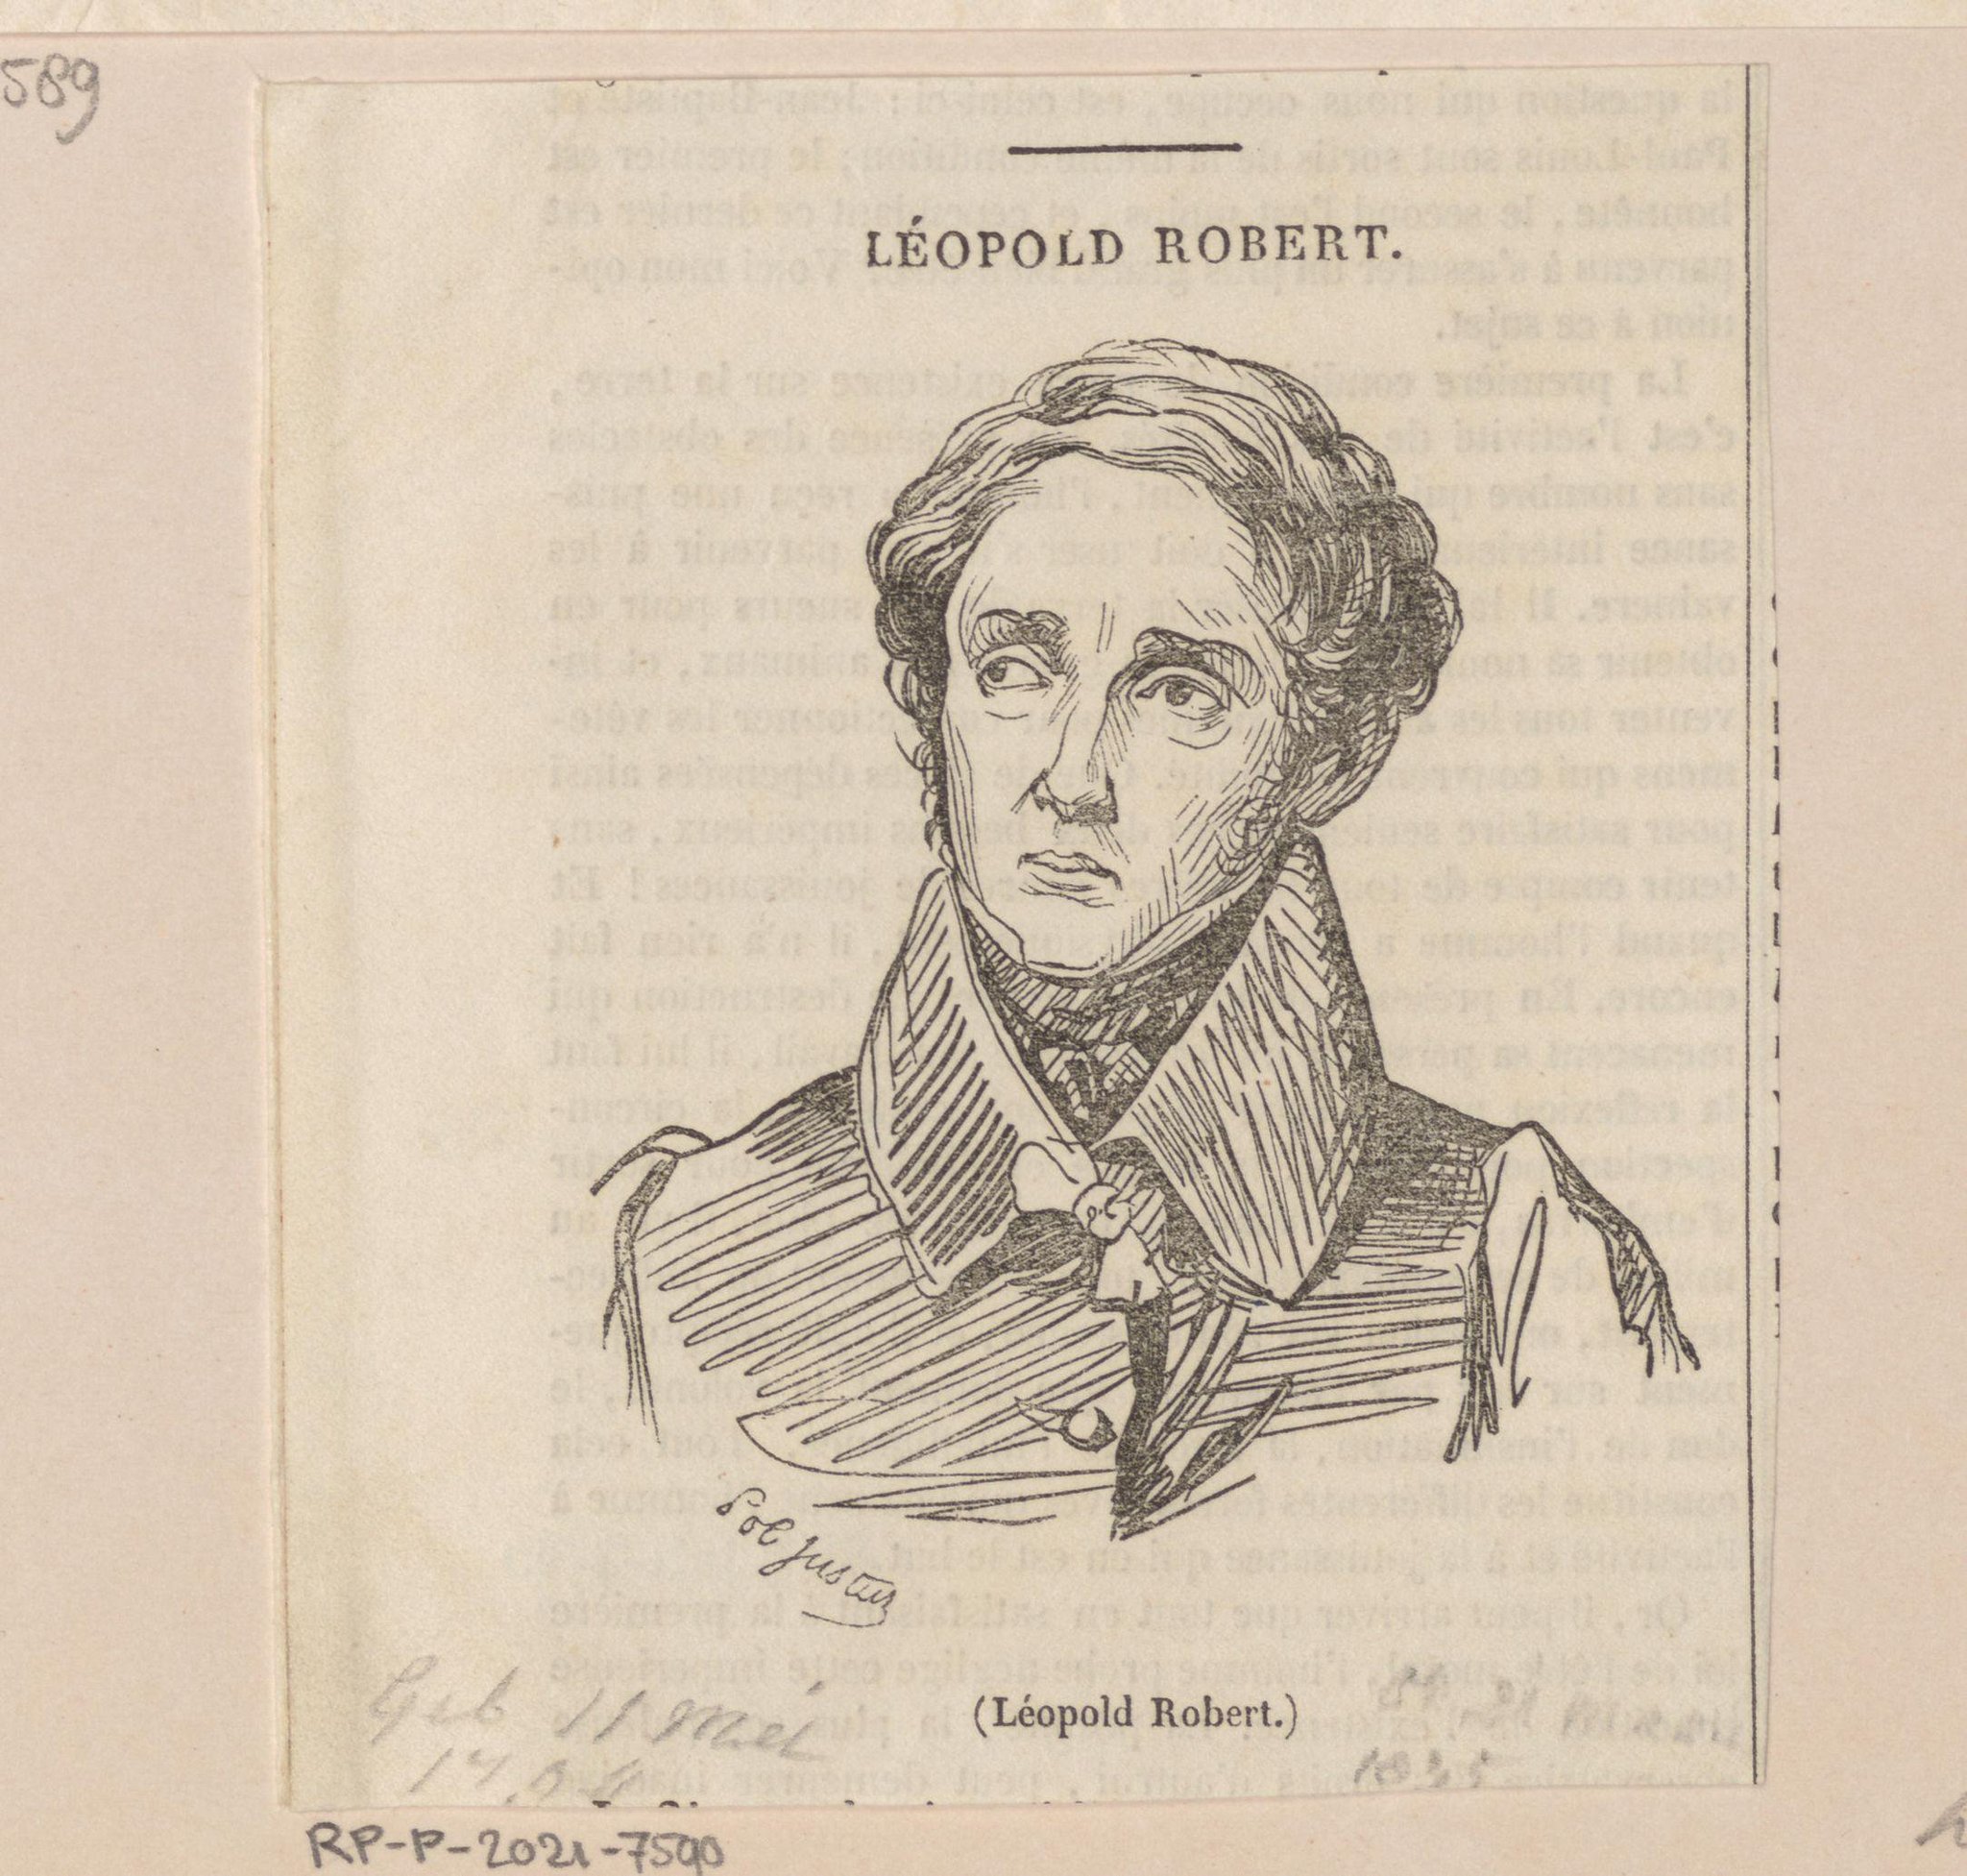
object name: photomechanical print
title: Portret van Louis Léopold Robert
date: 1835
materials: paper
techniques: letterpress printing, line block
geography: paris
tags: print maker, louis léopold robert, historical persons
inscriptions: signature: ‘Gol Justus’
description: Prent uit: Le magasin pittoresque, vol. 3, 1835.